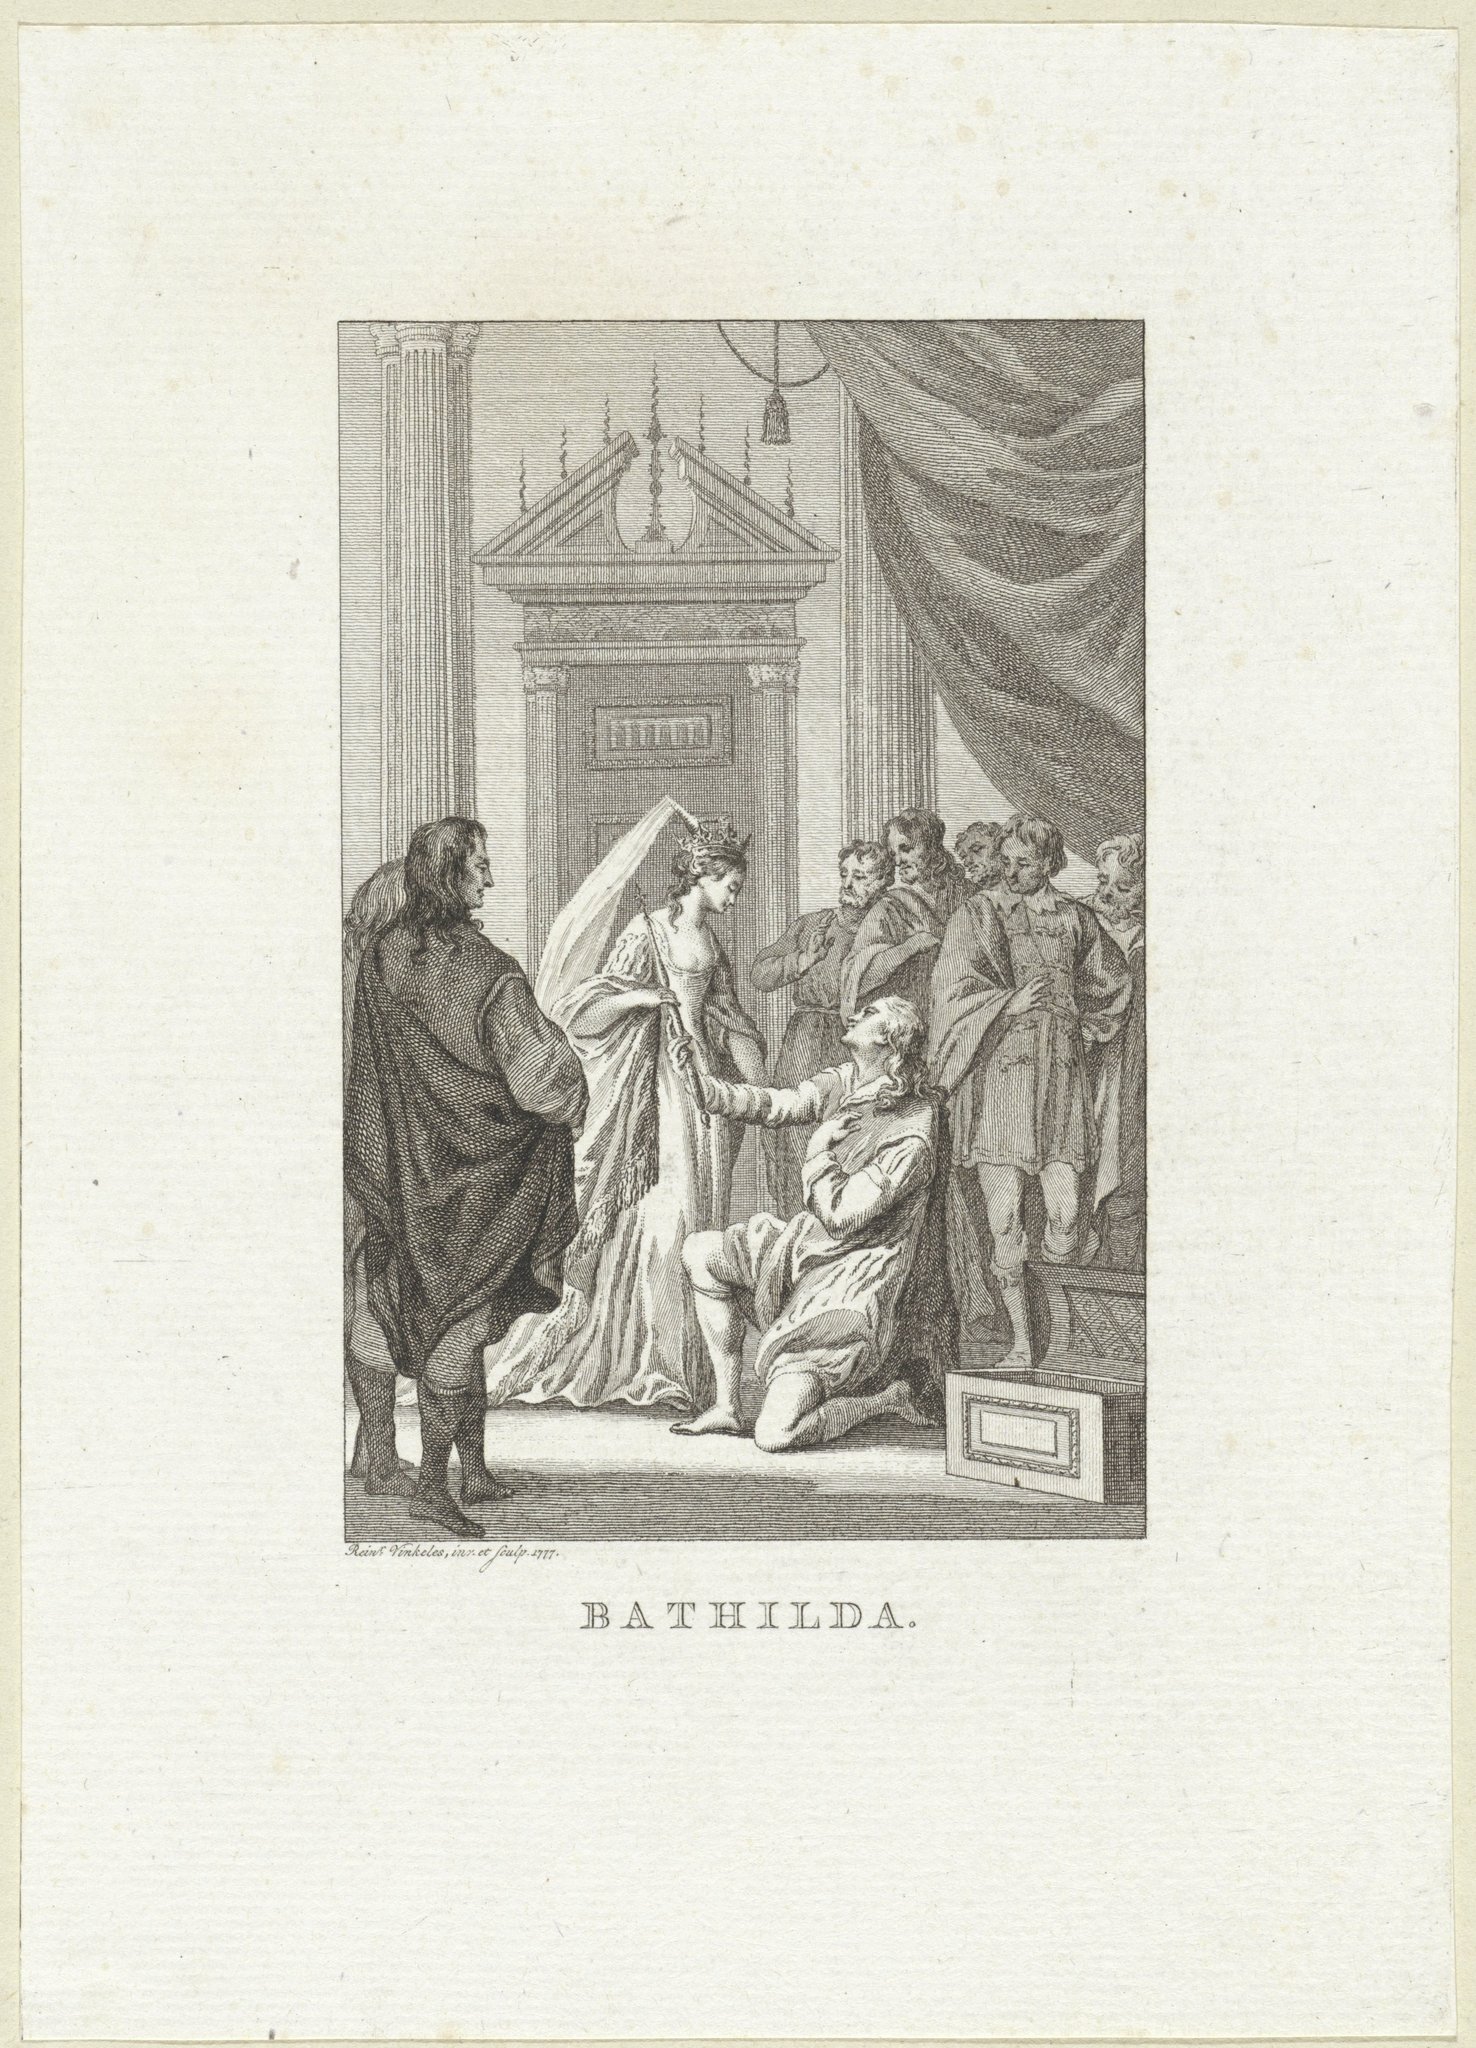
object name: print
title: Heer knielt voor een koningin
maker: reinier vinkeles (i)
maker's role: draughtsman, print maker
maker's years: 1741-1816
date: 1777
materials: paper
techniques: engraving, etching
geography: amsterdam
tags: crown (symbol of sovereignty), sceptre, staff (symbol of sovereignty), ruler, sovereign - bb - female ruler, kneeling figure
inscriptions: collector's mark: Lugt 240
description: Deze prent is ook gebruikt als illustratie bij het verhaal 'Bathilda' voor: Baculard d'Arnaud, F.T.M. de. Zedelijke verhaalen, deel 2. Amsterdam: A. Mens Jansz. en A.E. Munnikhuisen, 1777.